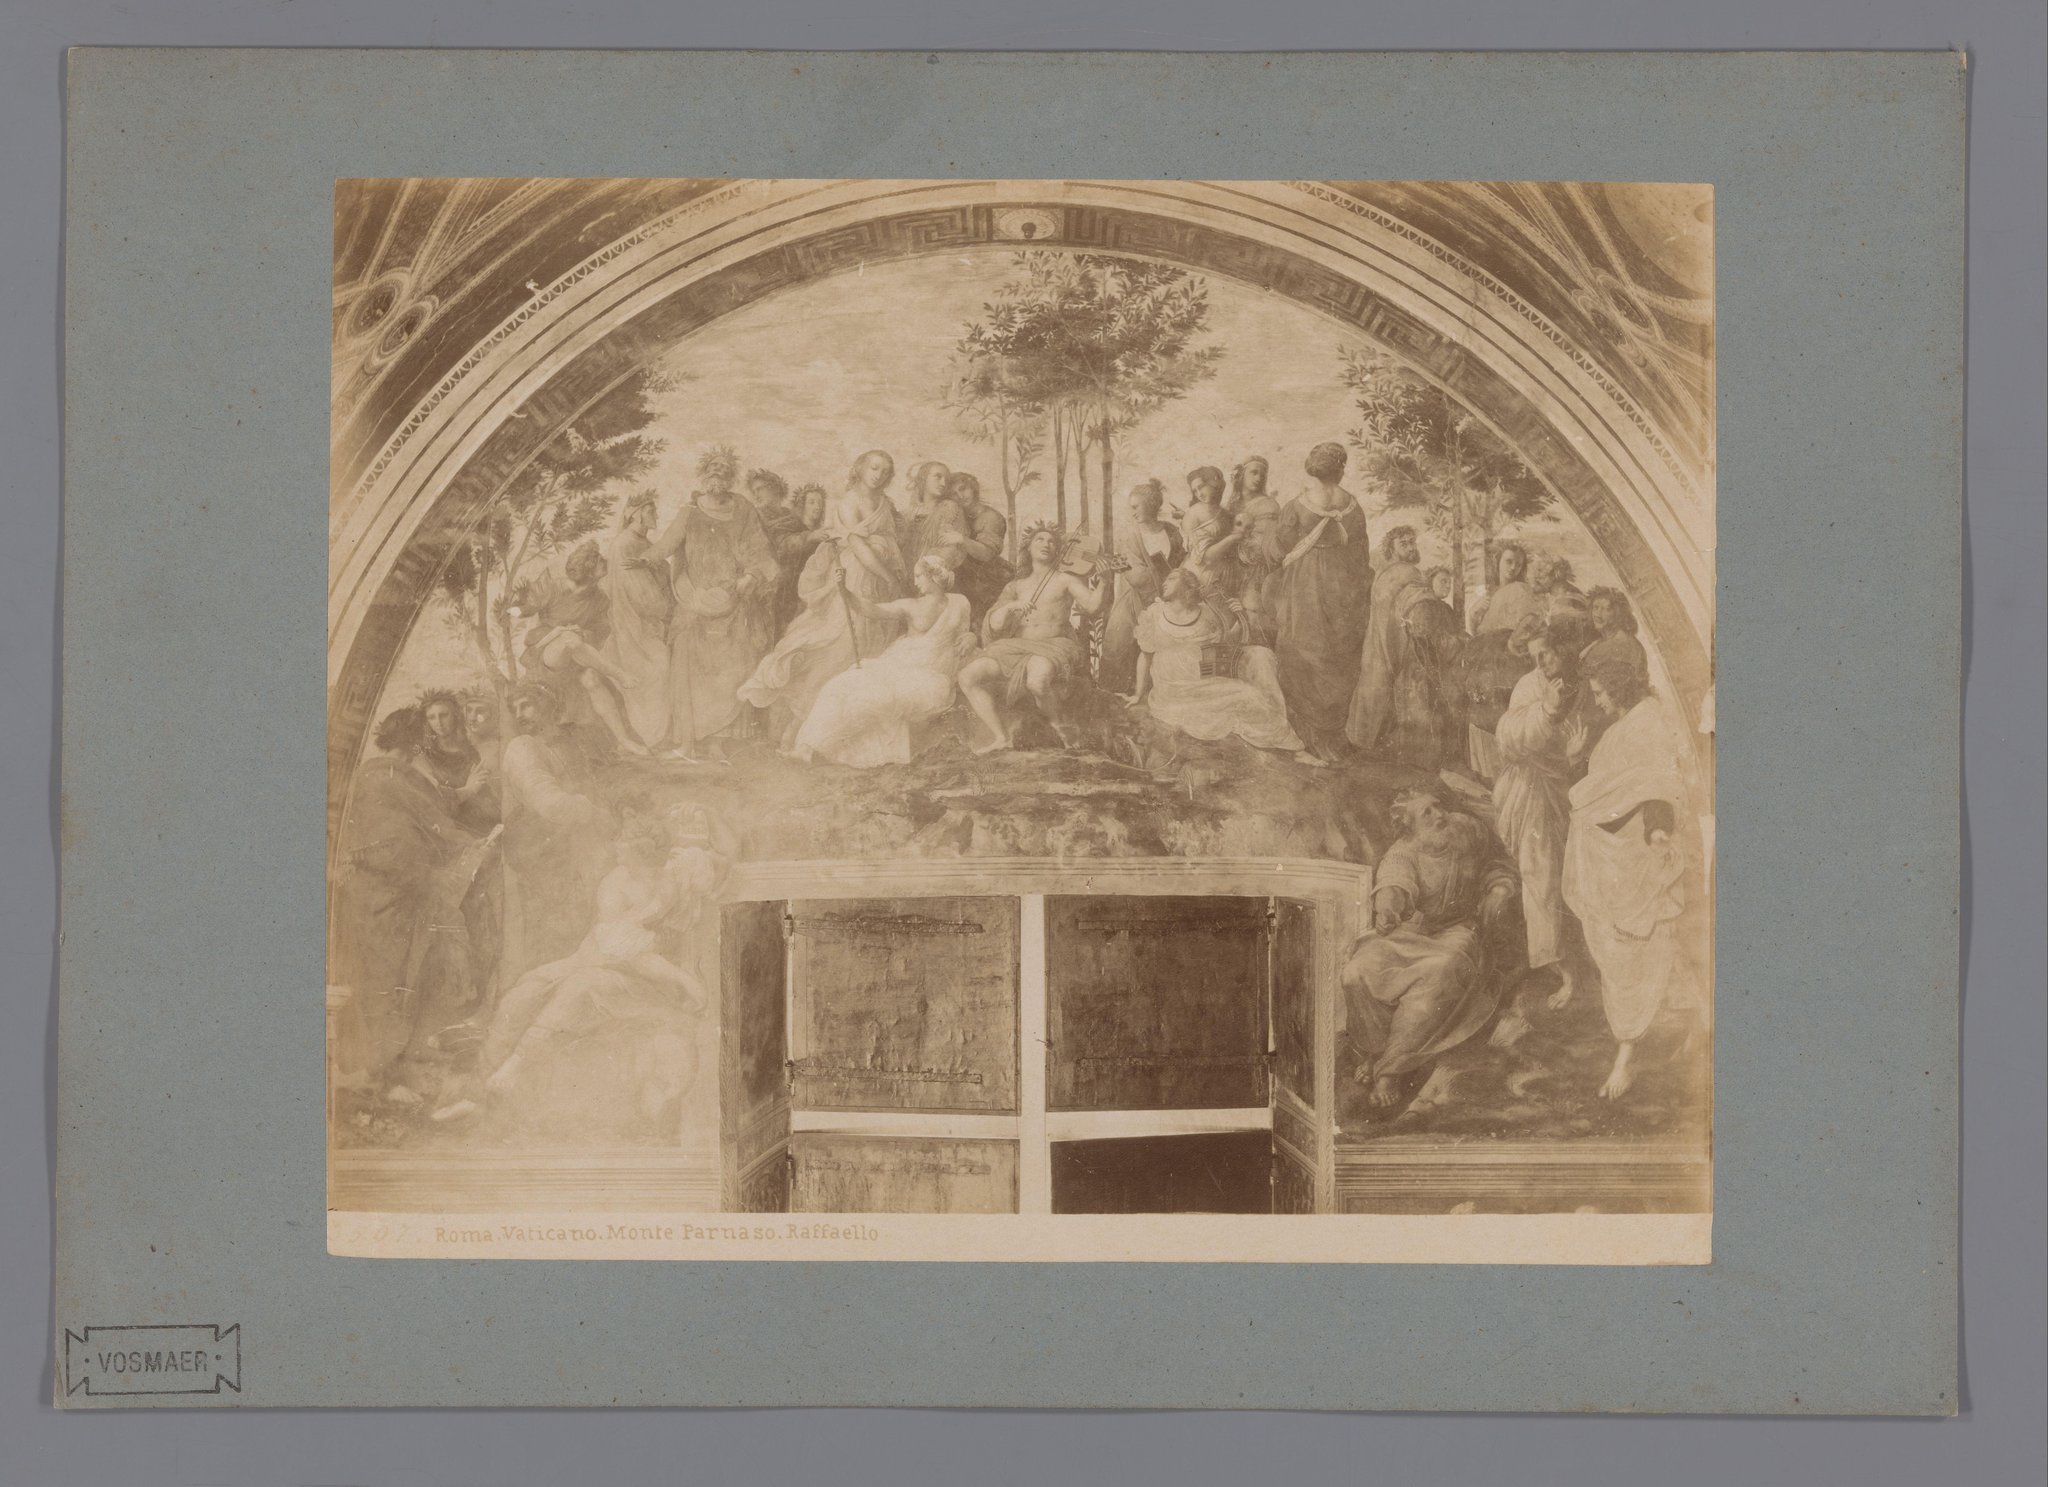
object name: photograph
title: Roma. Vaticano. Monte Parnaso. Raffaello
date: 1851-1900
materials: cardboard, paper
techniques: albumen print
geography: vatican city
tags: picture, painting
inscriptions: collector's mark: ‘VOSMAER’